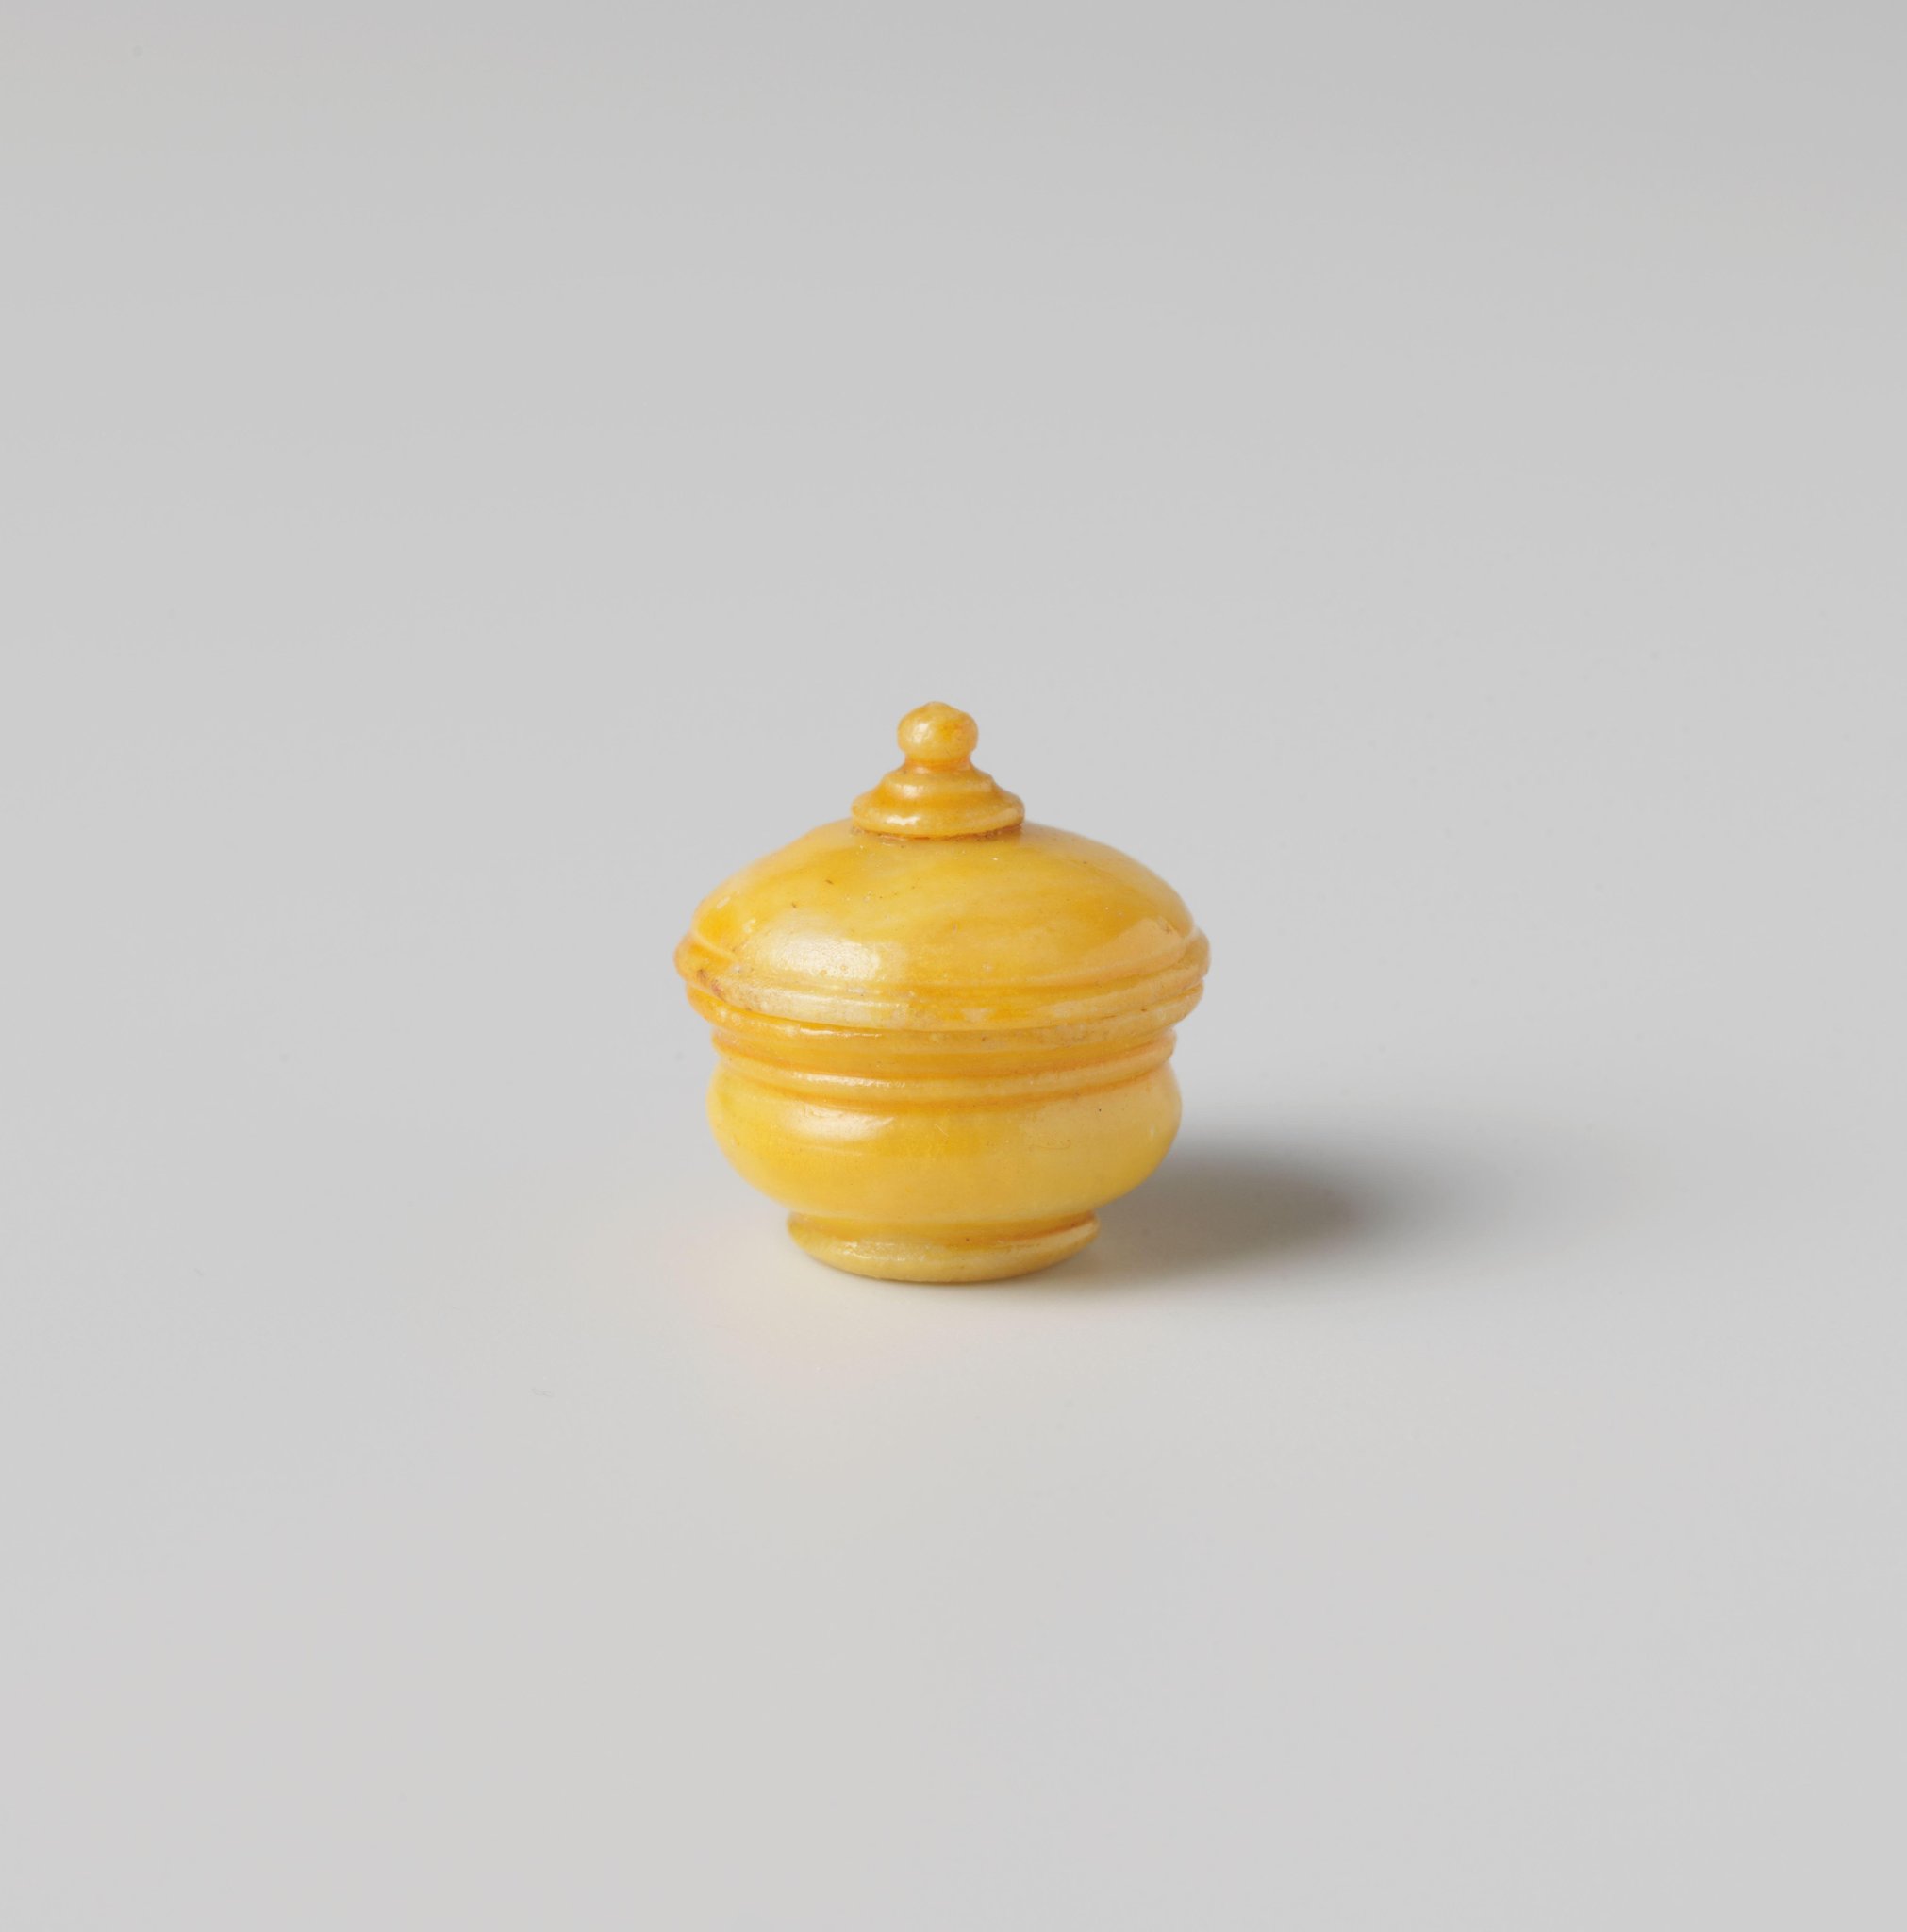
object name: miniature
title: Suikerpot met deksel, geelgelakt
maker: Anonymous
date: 1750-1800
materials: alabaster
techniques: lacquer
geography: germany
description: Suikerpot van geelgelakt albast, versierd met gedraaide profielranden. De deksel is los en heeft een knop en profielranden.